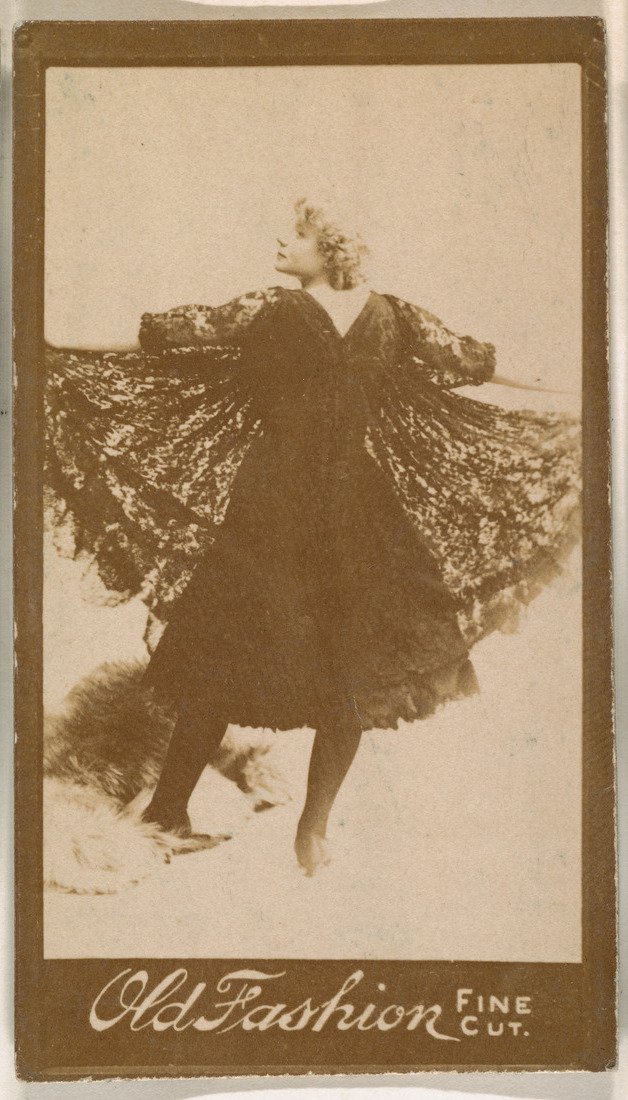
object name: photograph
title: Dancer with lace skirt, from the Actresses series (N664) promoting Old Fashion Fine Cut Tobacco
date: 1888-1890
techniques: albumen silver print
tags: portraits,women,actresses,dancers